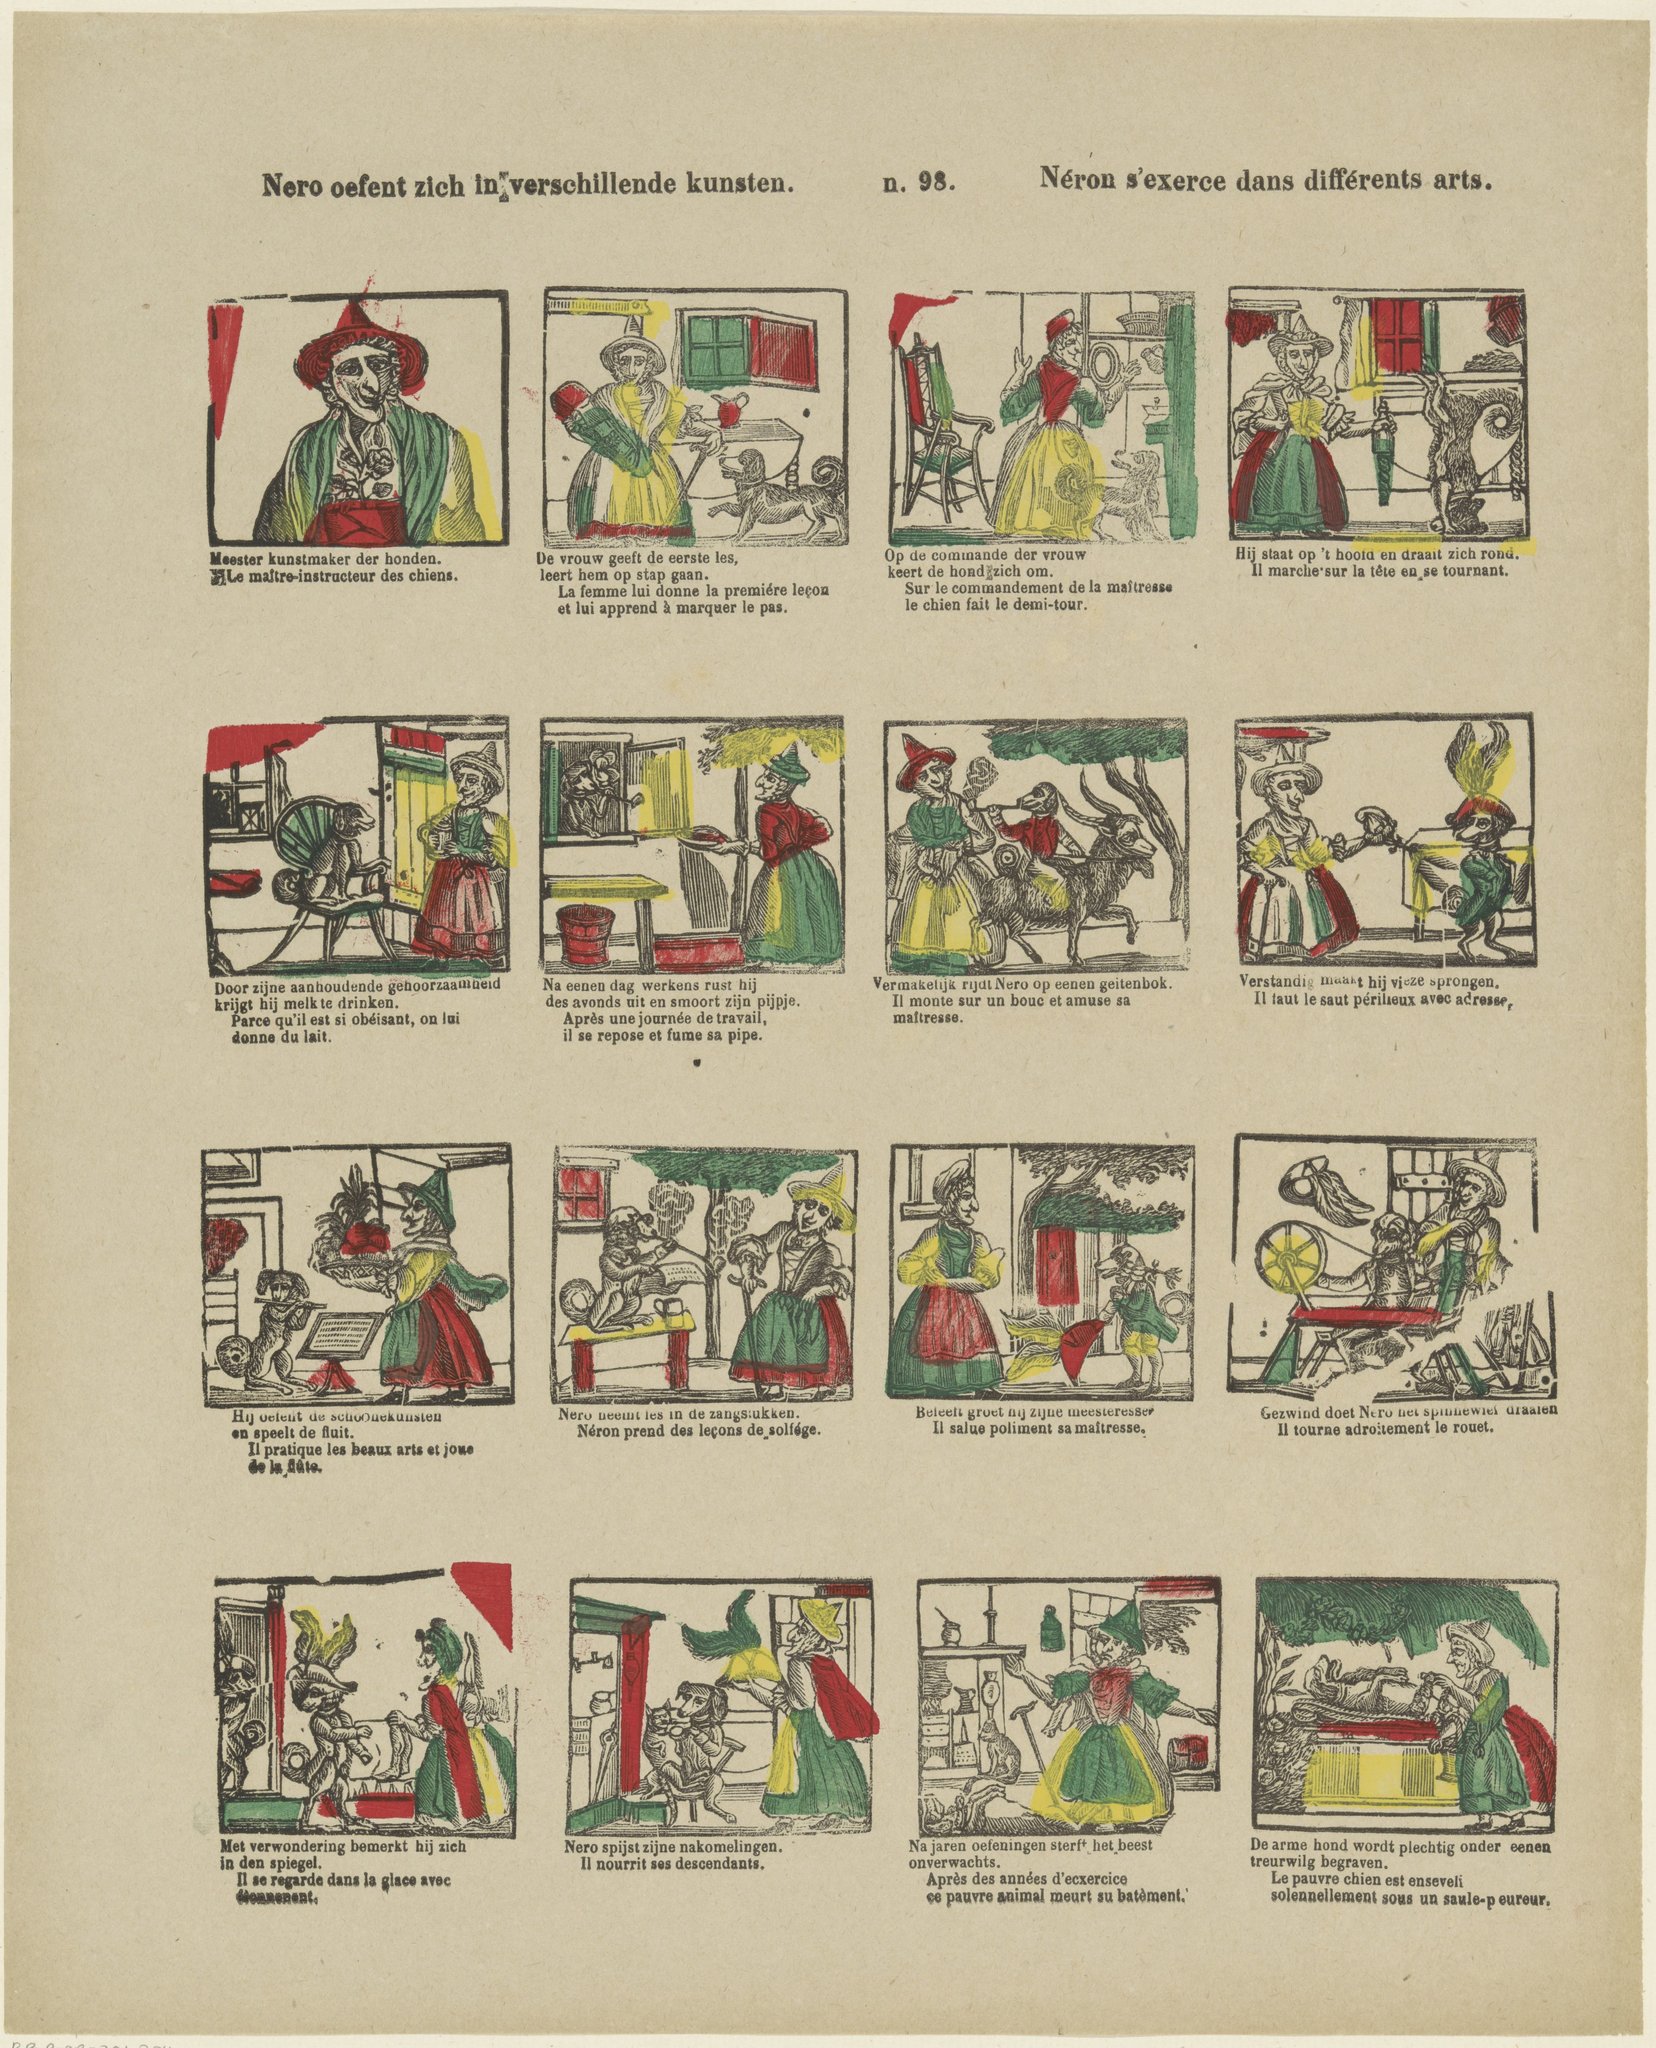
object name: popular print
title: Nero oefent zich in verschillende kunsten / Néron s'exerce dans différents arts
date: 1866-1902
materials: paper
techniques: colour, letterpress printing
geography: europe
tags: animals acting as human beings, dog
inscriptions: collector's mark: Lugt 2760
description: Blad met 16 voorstellingen van de hond Nero die kunstjes geleerd krijgt van zijn bazin. Onder elke afbeelding een tweeregelig vers in het Nederlands en in het Frans. Genummerd midden boven: n. 98.